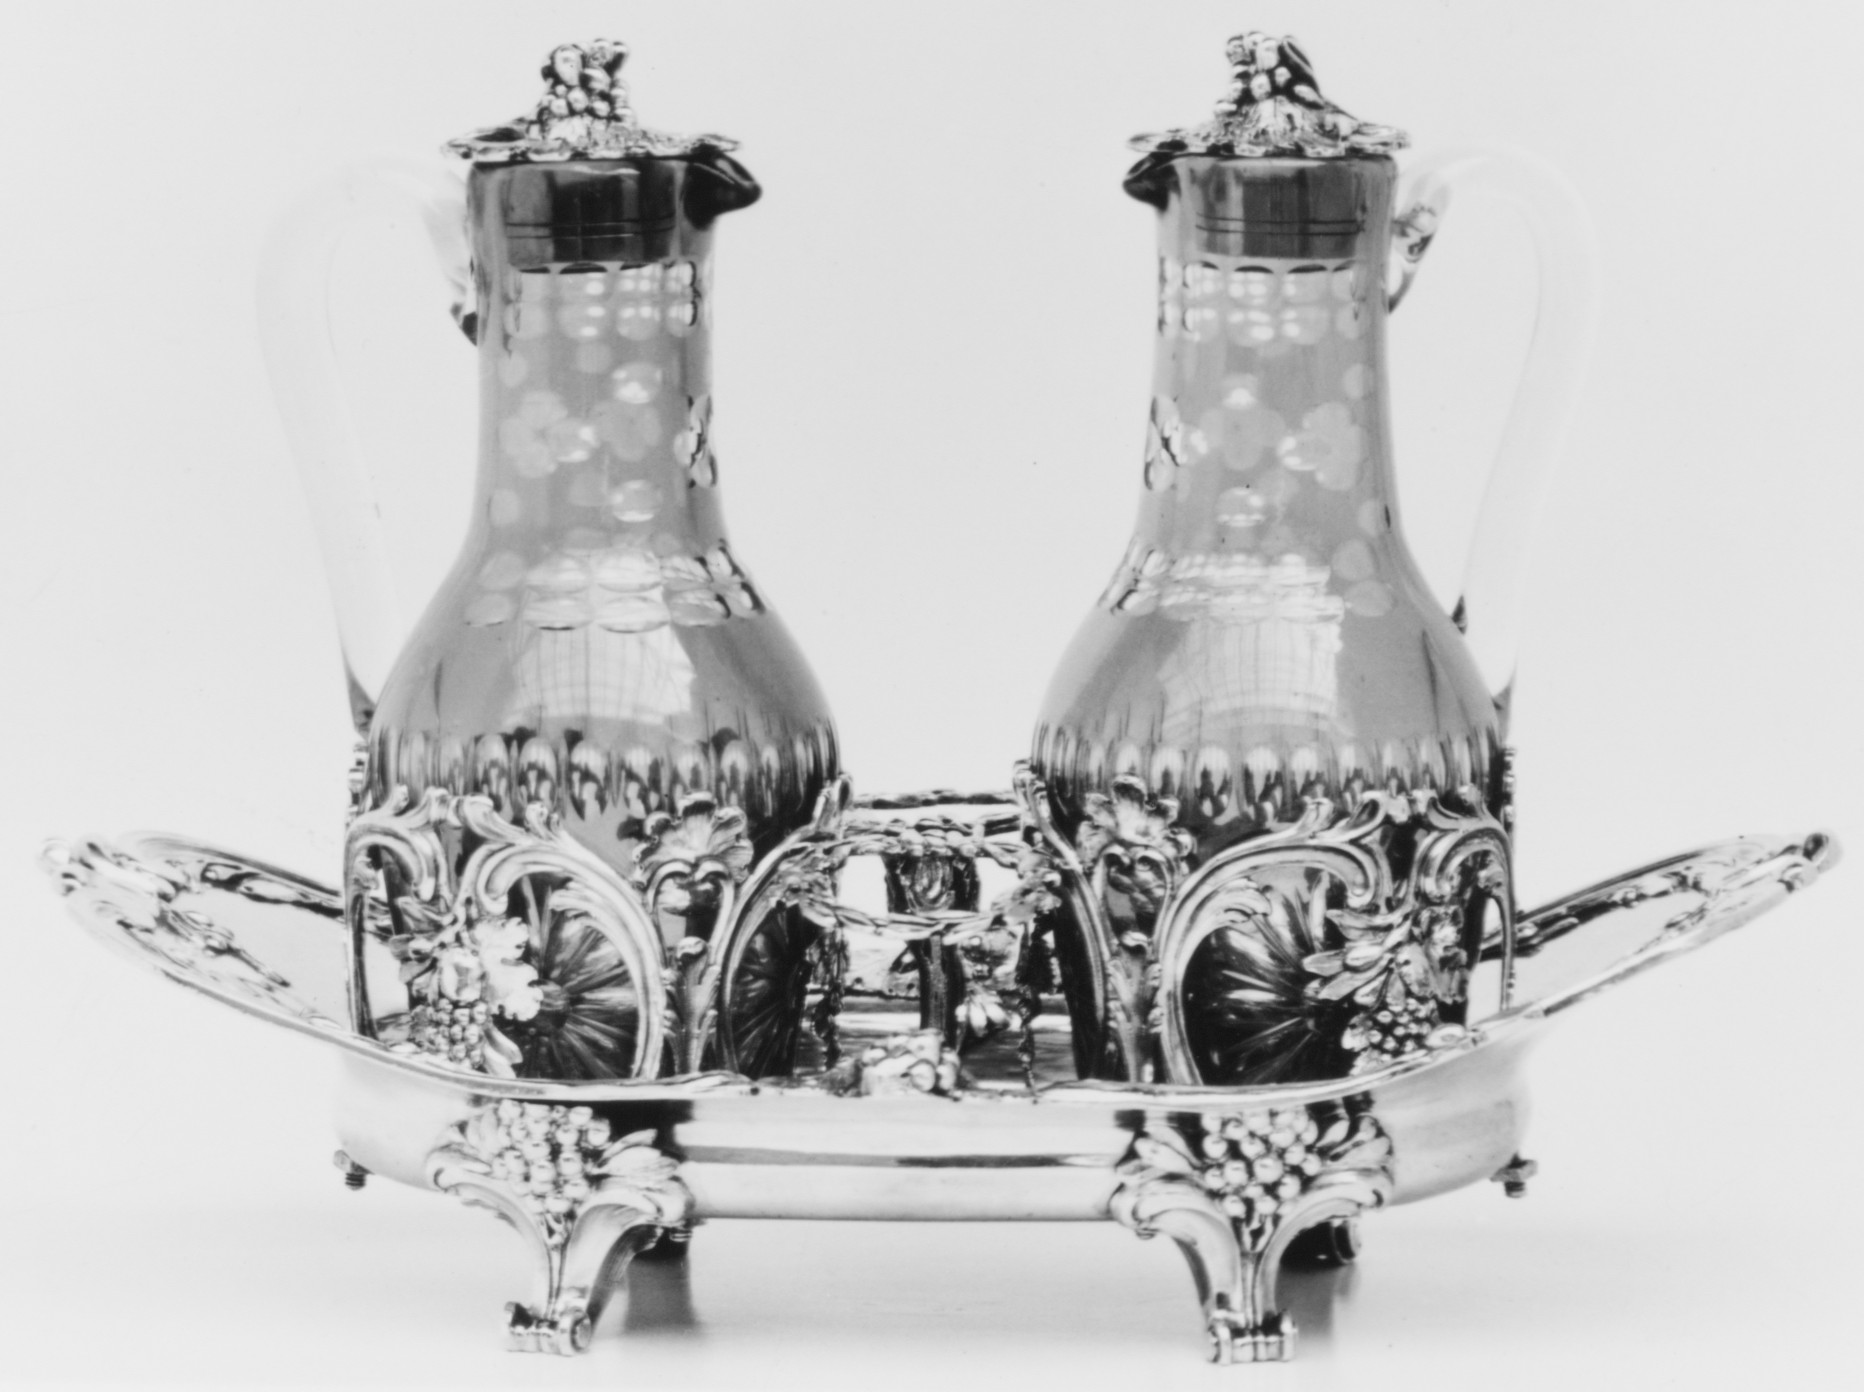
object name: cruet stand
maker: joseph-pierre-jacques duguay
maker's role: maker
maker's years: 1724-1824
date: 1762-1763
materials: glass, silver